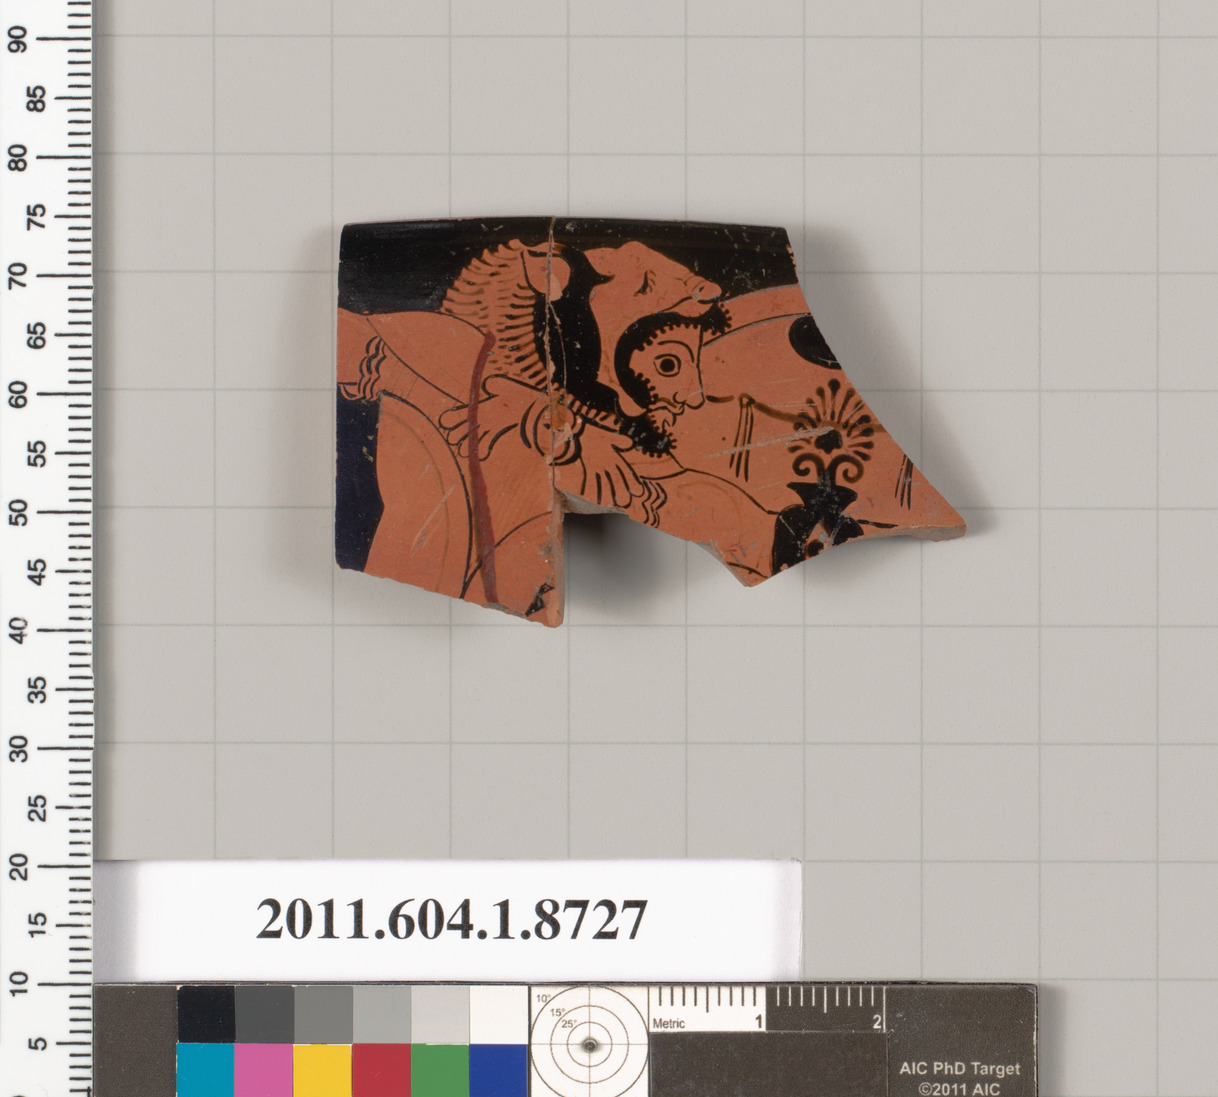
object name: cup skyphos fragment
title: Terracotta rim fragment of a cup-skyphos (drinking cup)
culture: greek, attic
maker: kleophrades painter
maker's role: artist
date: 500-490 BCE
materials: terracotta